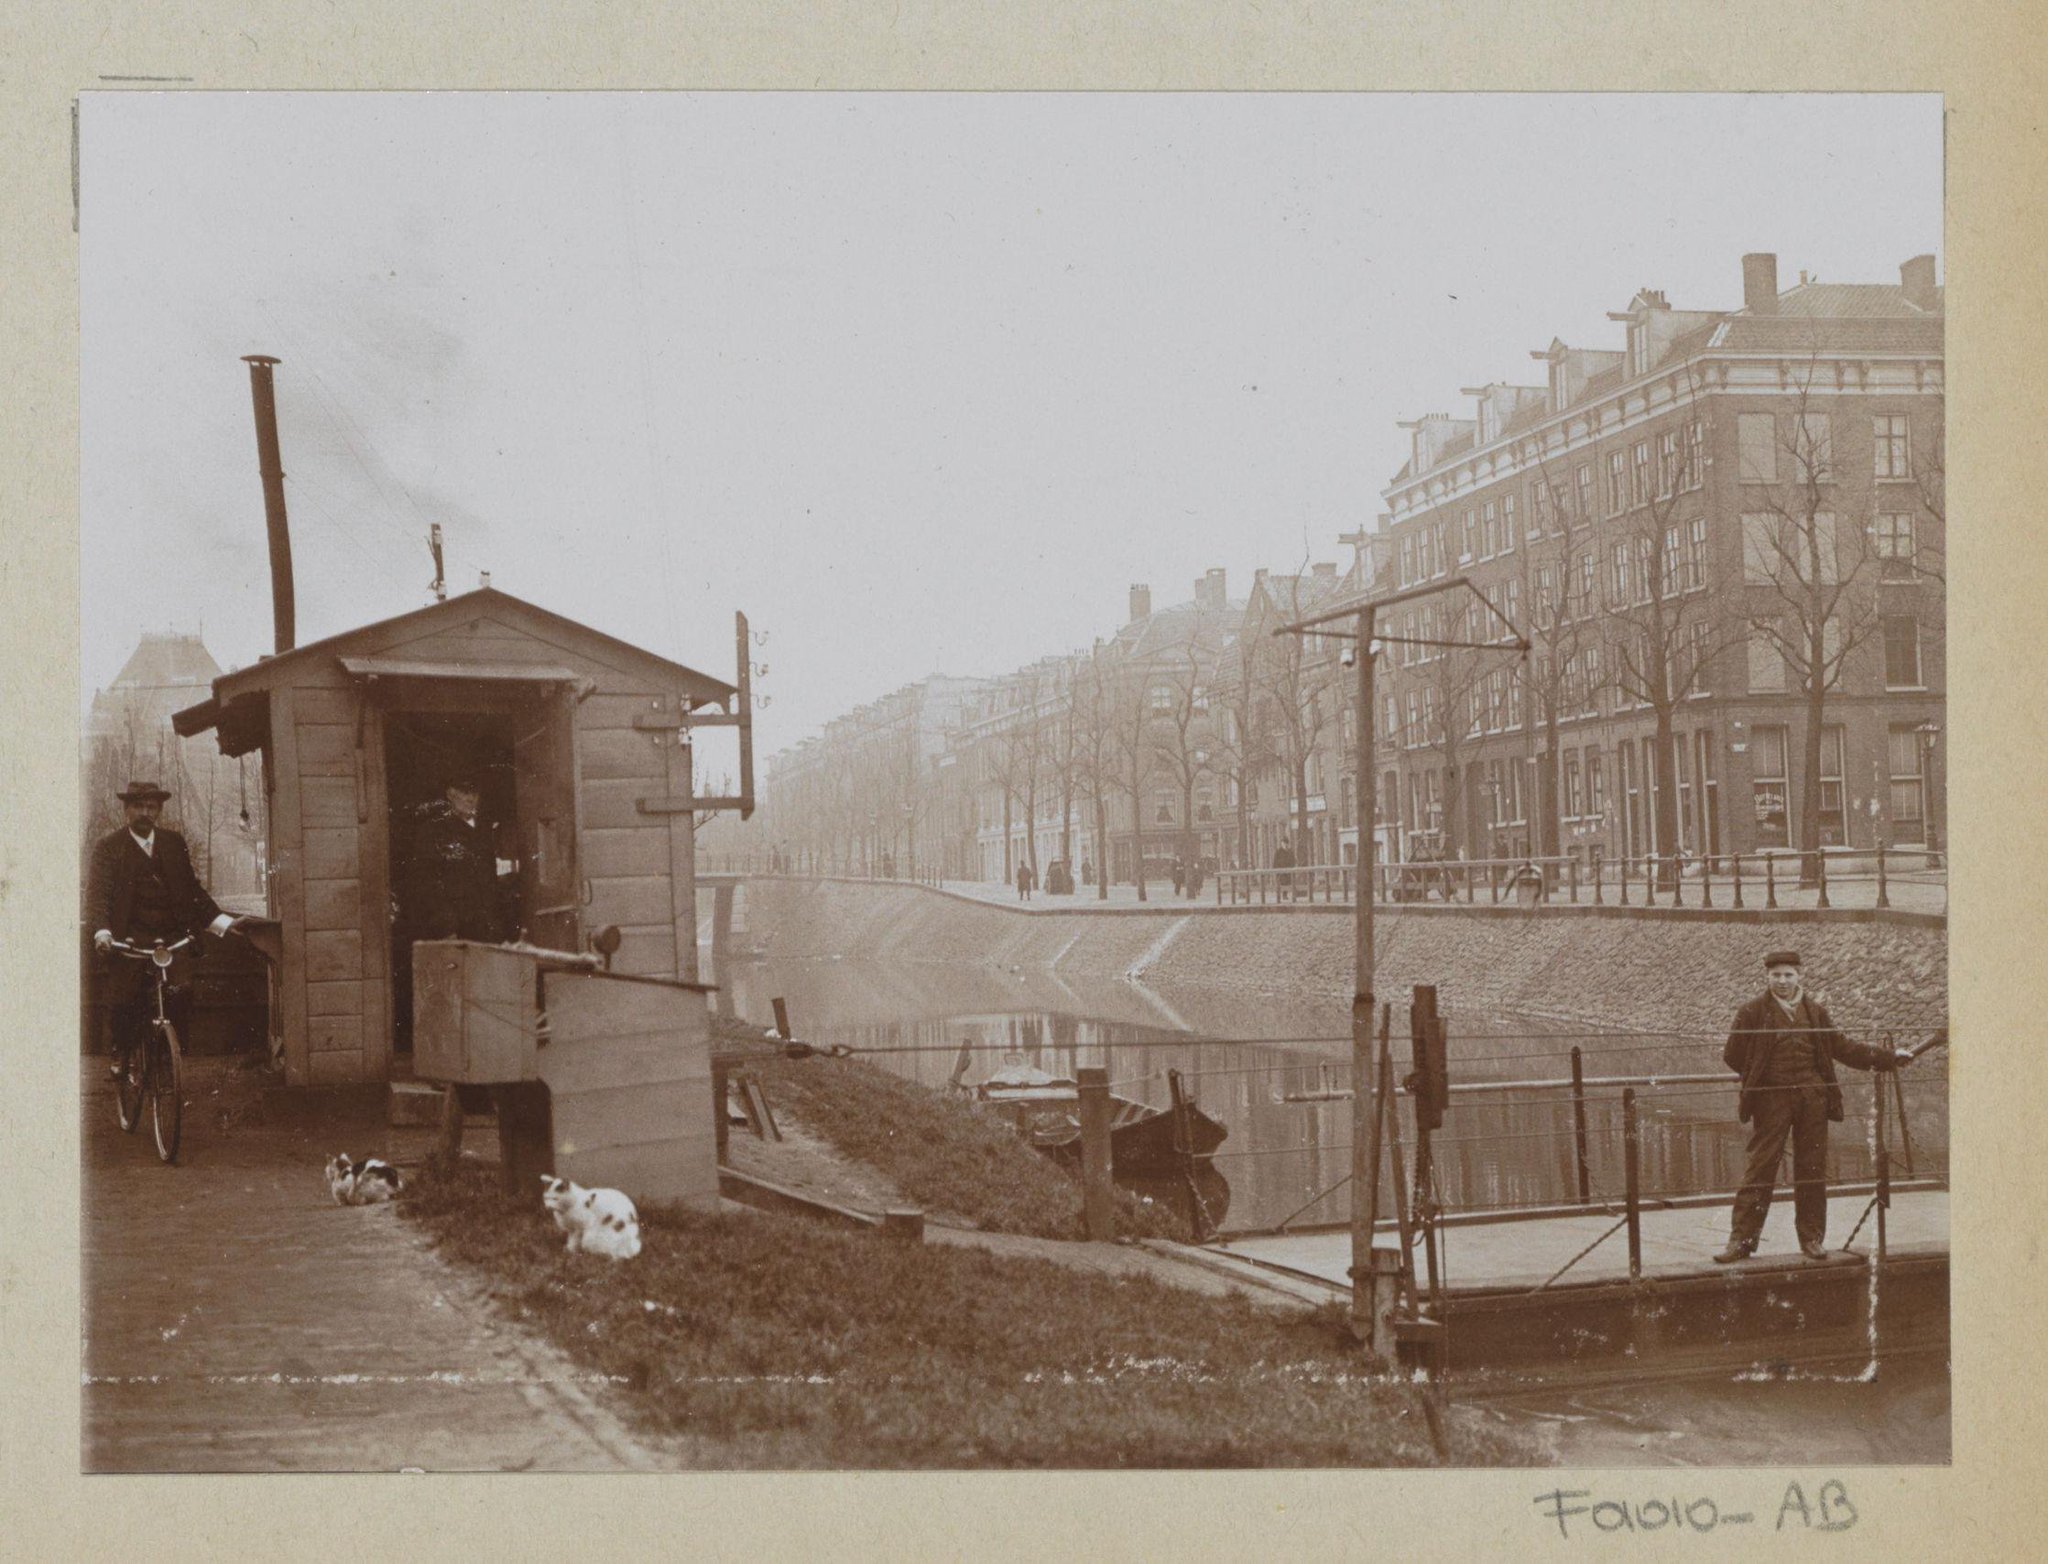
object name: photograph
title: Mannen, vermoedelijk werknemers, en twee katten bij een aanlegsteiger en een wachthuisje langs een gracht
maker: Anonymous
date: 1900-1910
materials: photographic support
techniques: collodion silver print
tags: cat, canal, pier, quay, wharf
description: Onderdeel van Familiealbum met onder meer foto's van Wijnhandel Kraaij & Co. Bordeaux-Amsterdam.